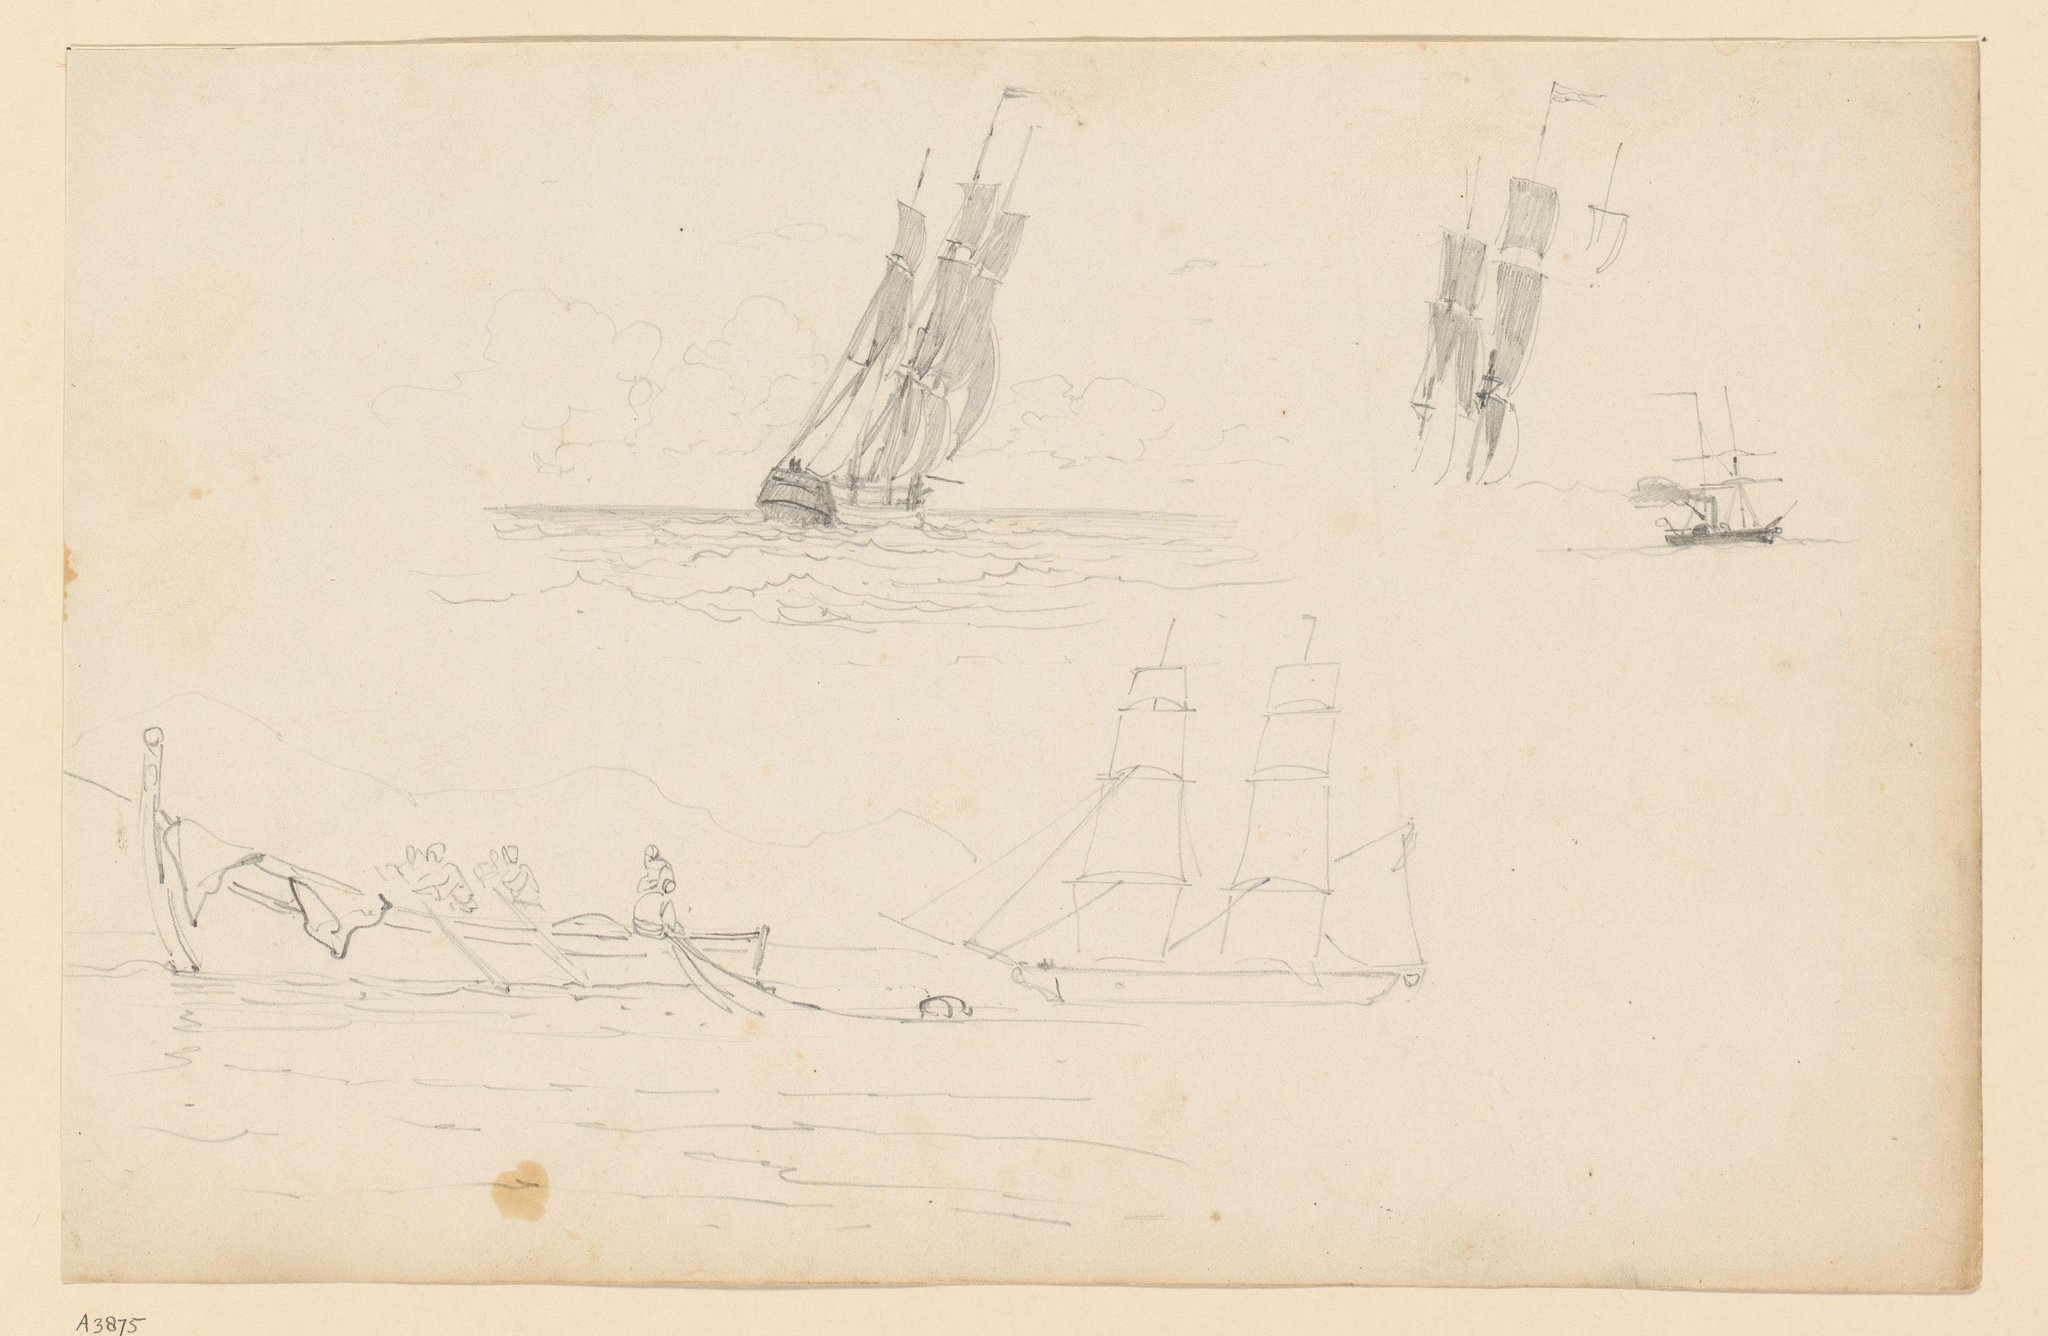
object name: drawing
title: Studies van zeilschepen en een roeiboot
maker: willem anthonie van deventer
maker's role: draughtsman, painter, print maker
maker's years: 1824-1893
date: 1834-1893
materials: paper, pencil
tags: sailing-ship, sailing-boat, rowing-boat, canoe, etc.